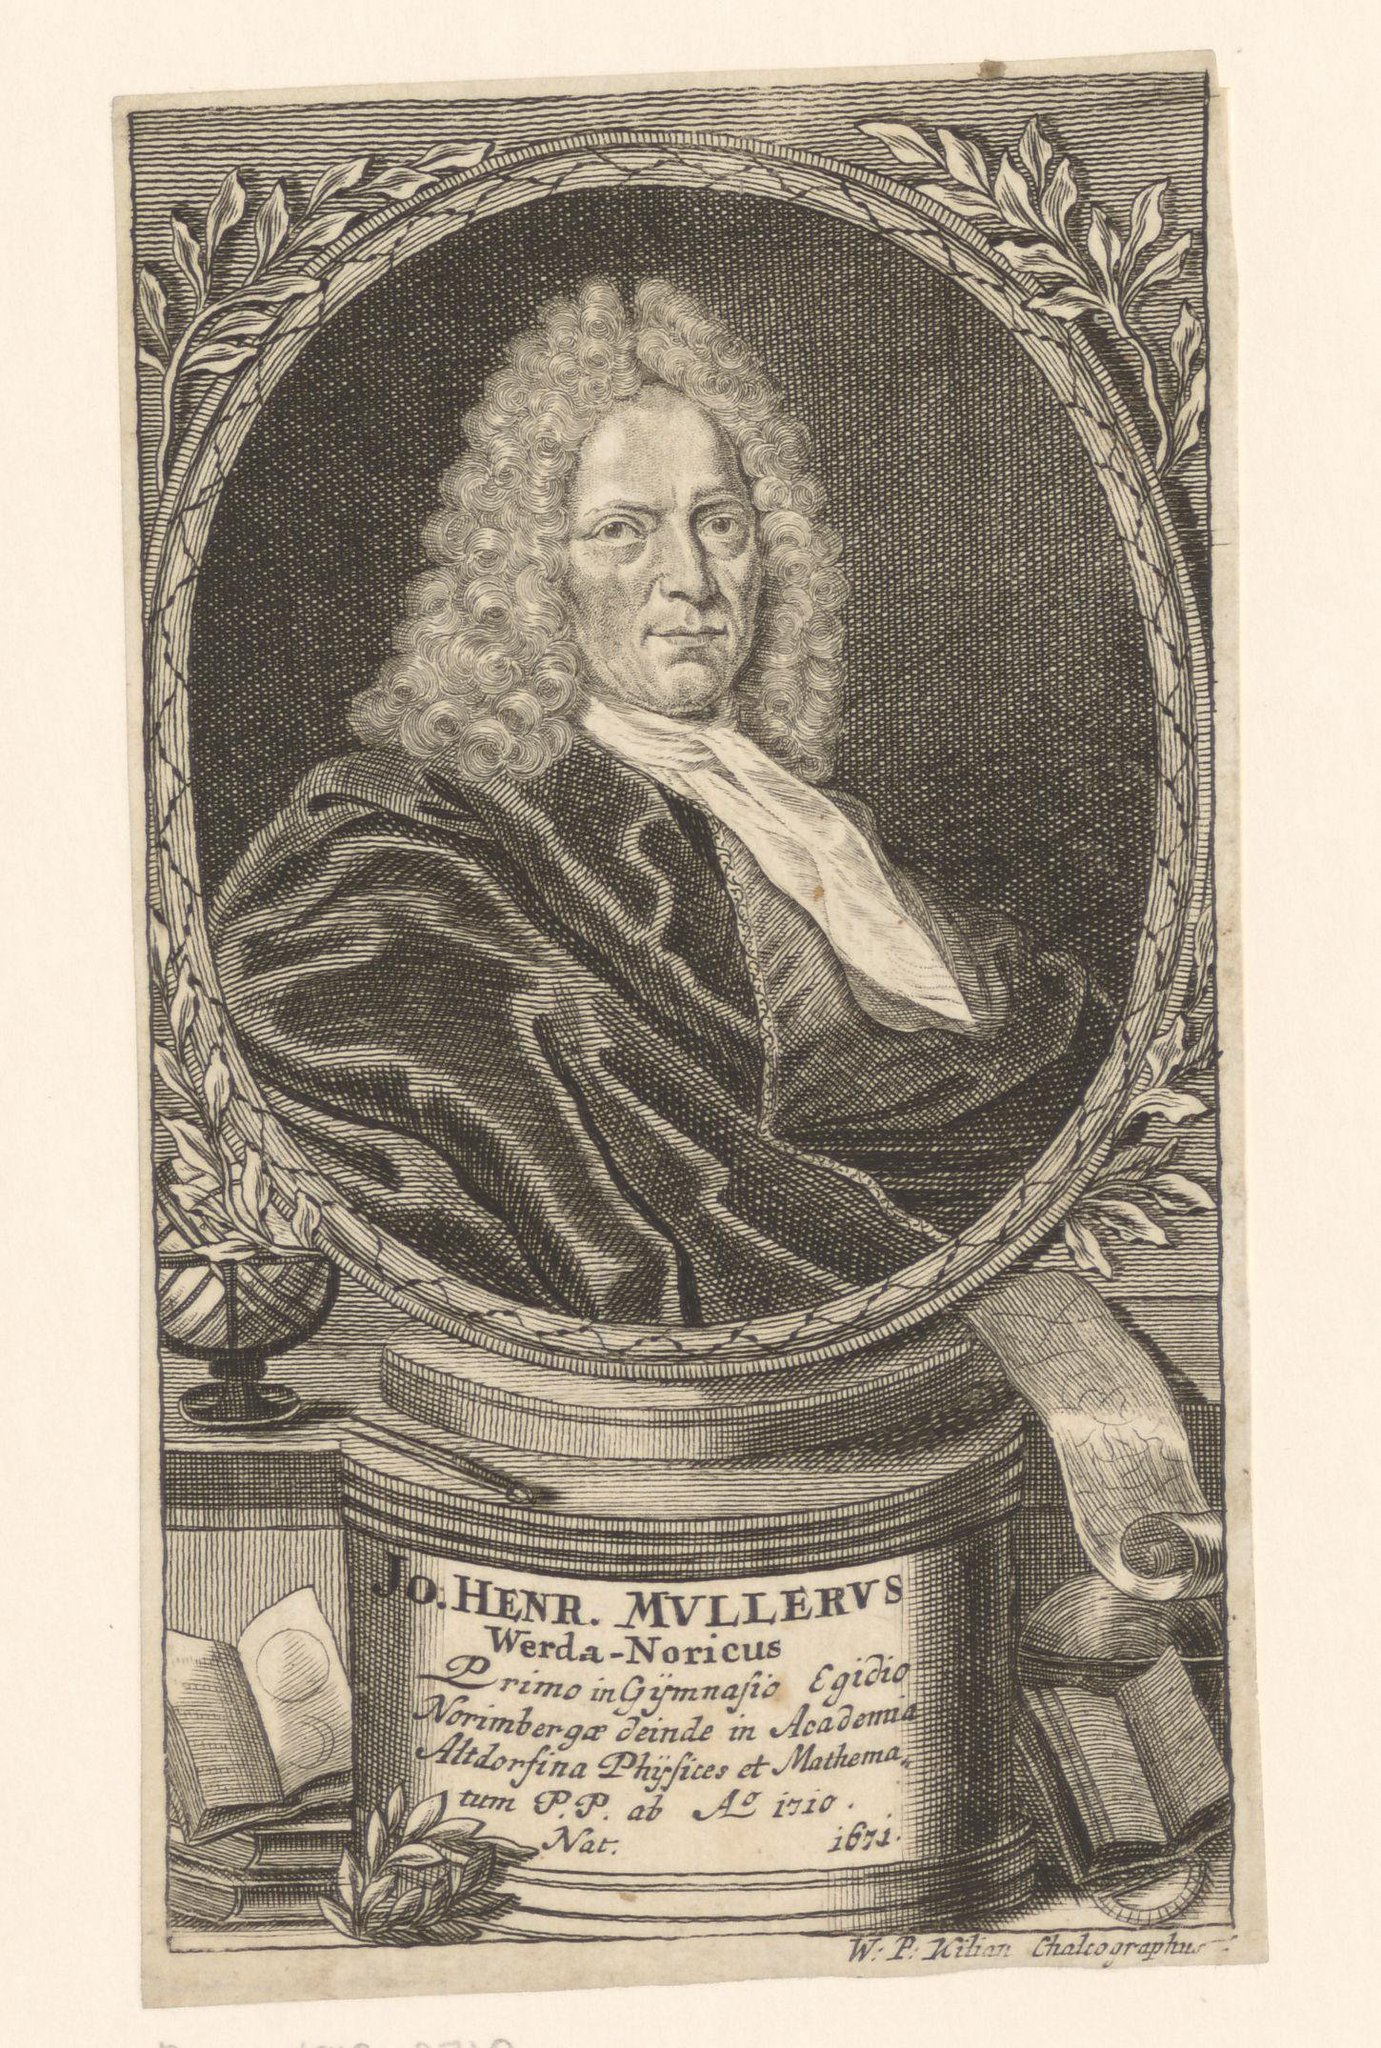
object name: print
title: Portret van Johann Heinrich Müller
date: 1681-1728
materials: paper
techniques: engraving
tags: physicist, astronomy (and cosmography) (+ portrait of scholar, scientist), physics and mechanics (+ portrait of scholar, scientist), further education (+ portrait of teacher, professor), historical persons, mathematics (+ portrait of scholar, scientist)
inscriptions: collector's mark: Lugt 2228